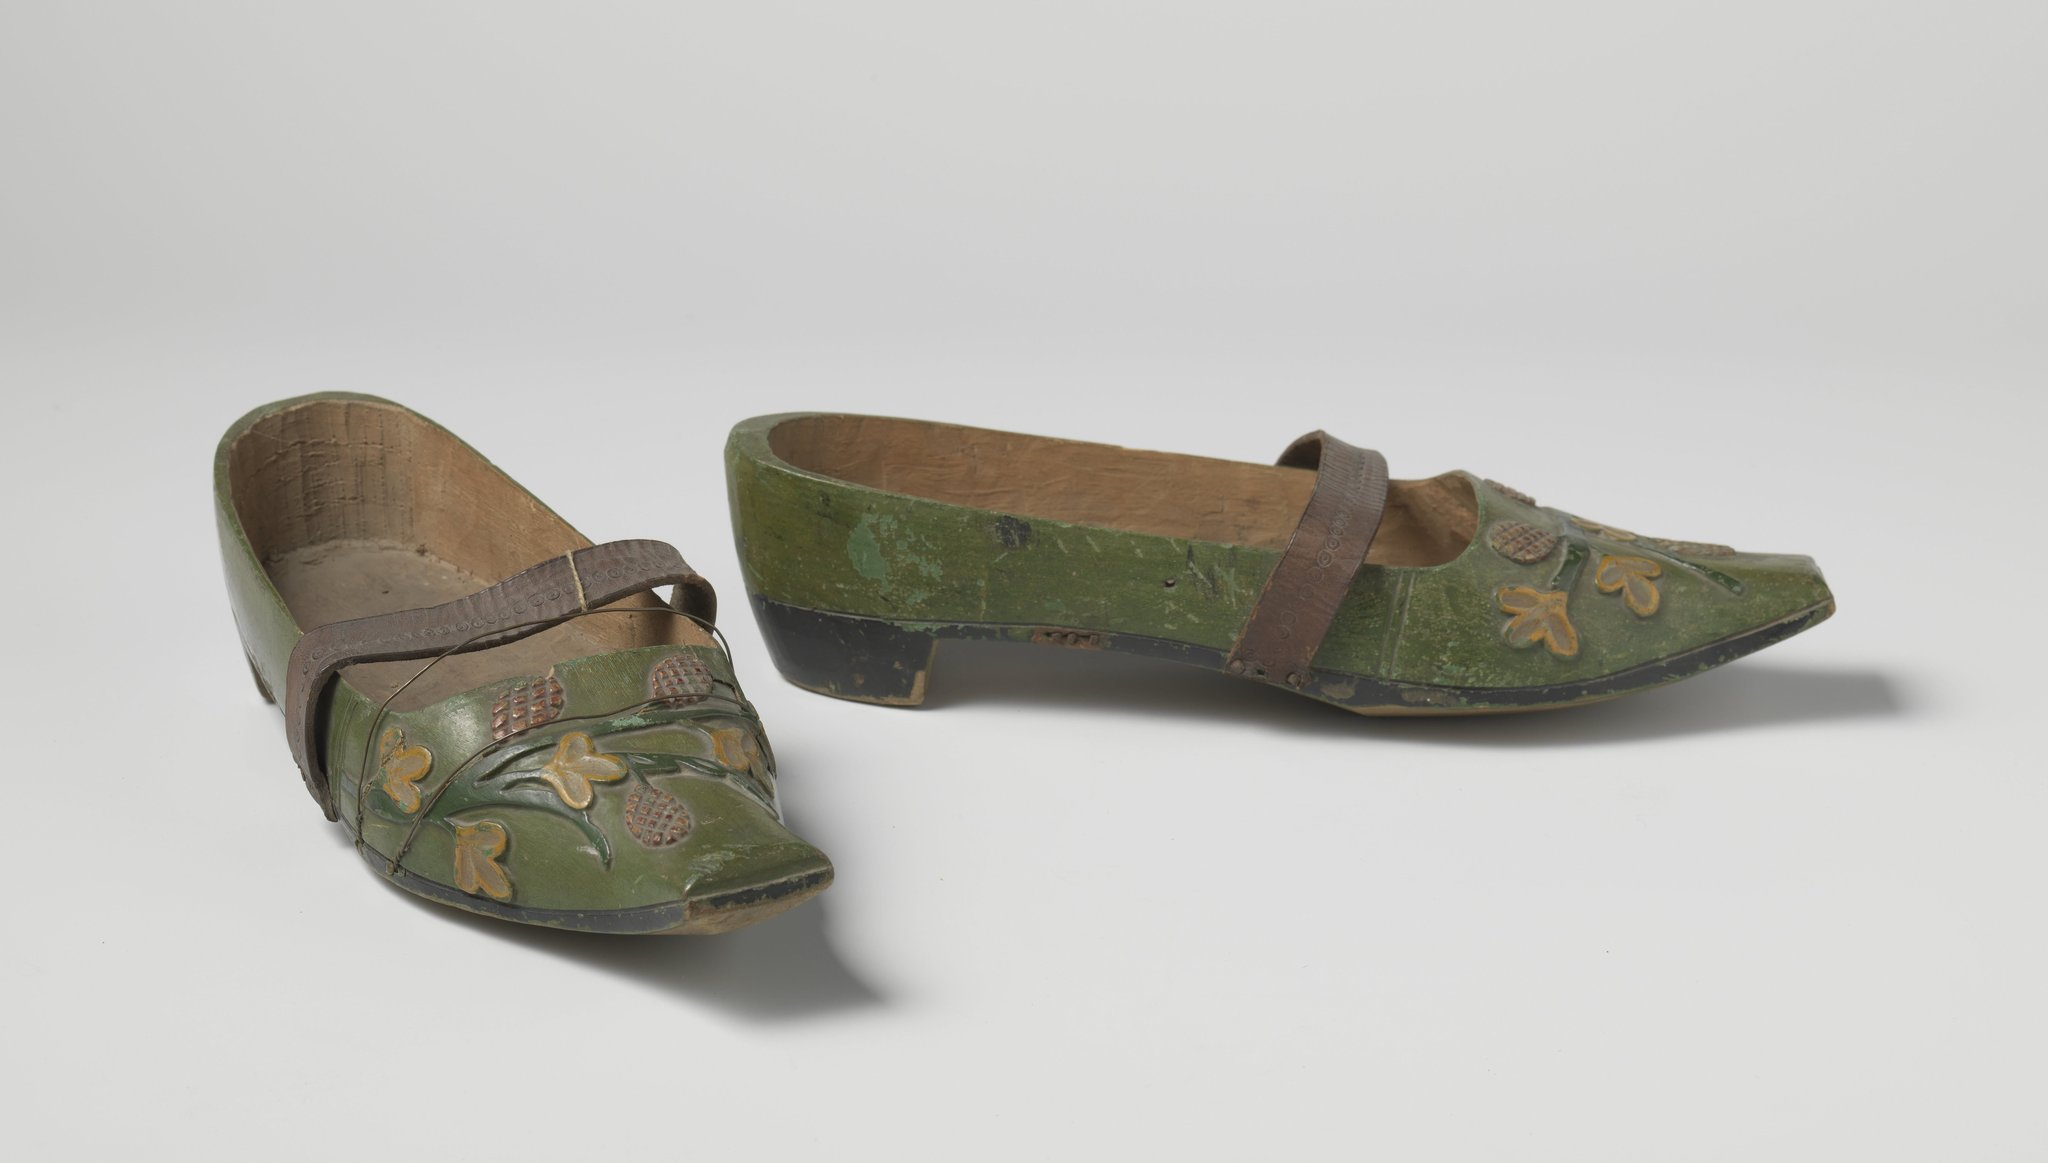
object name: womenswear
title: Damesklomp met een dekkende mosgroene verf beschilderd versierd met vrucht en bladranken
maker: Anonymous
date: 1830-1870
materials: iron, leather, paint, wood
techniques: cutting, painting, tanning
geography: northern netherlands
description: Damesklomp met een dekkende mosgroene verf beschilderd. Model: De voorschoen loopt smal toe en eindigt in een vierkante neus. Leren versierde band over de wreef aan beide kanten vastgemaakt met twee spijkertjes. Binnenkant schoen ongeschilderd hout. Houten zool en zwart geschilderde lage hak. Versiering: Op de voorvoet zijn in reliëf ranken met bloemen en bladeren gesneden.